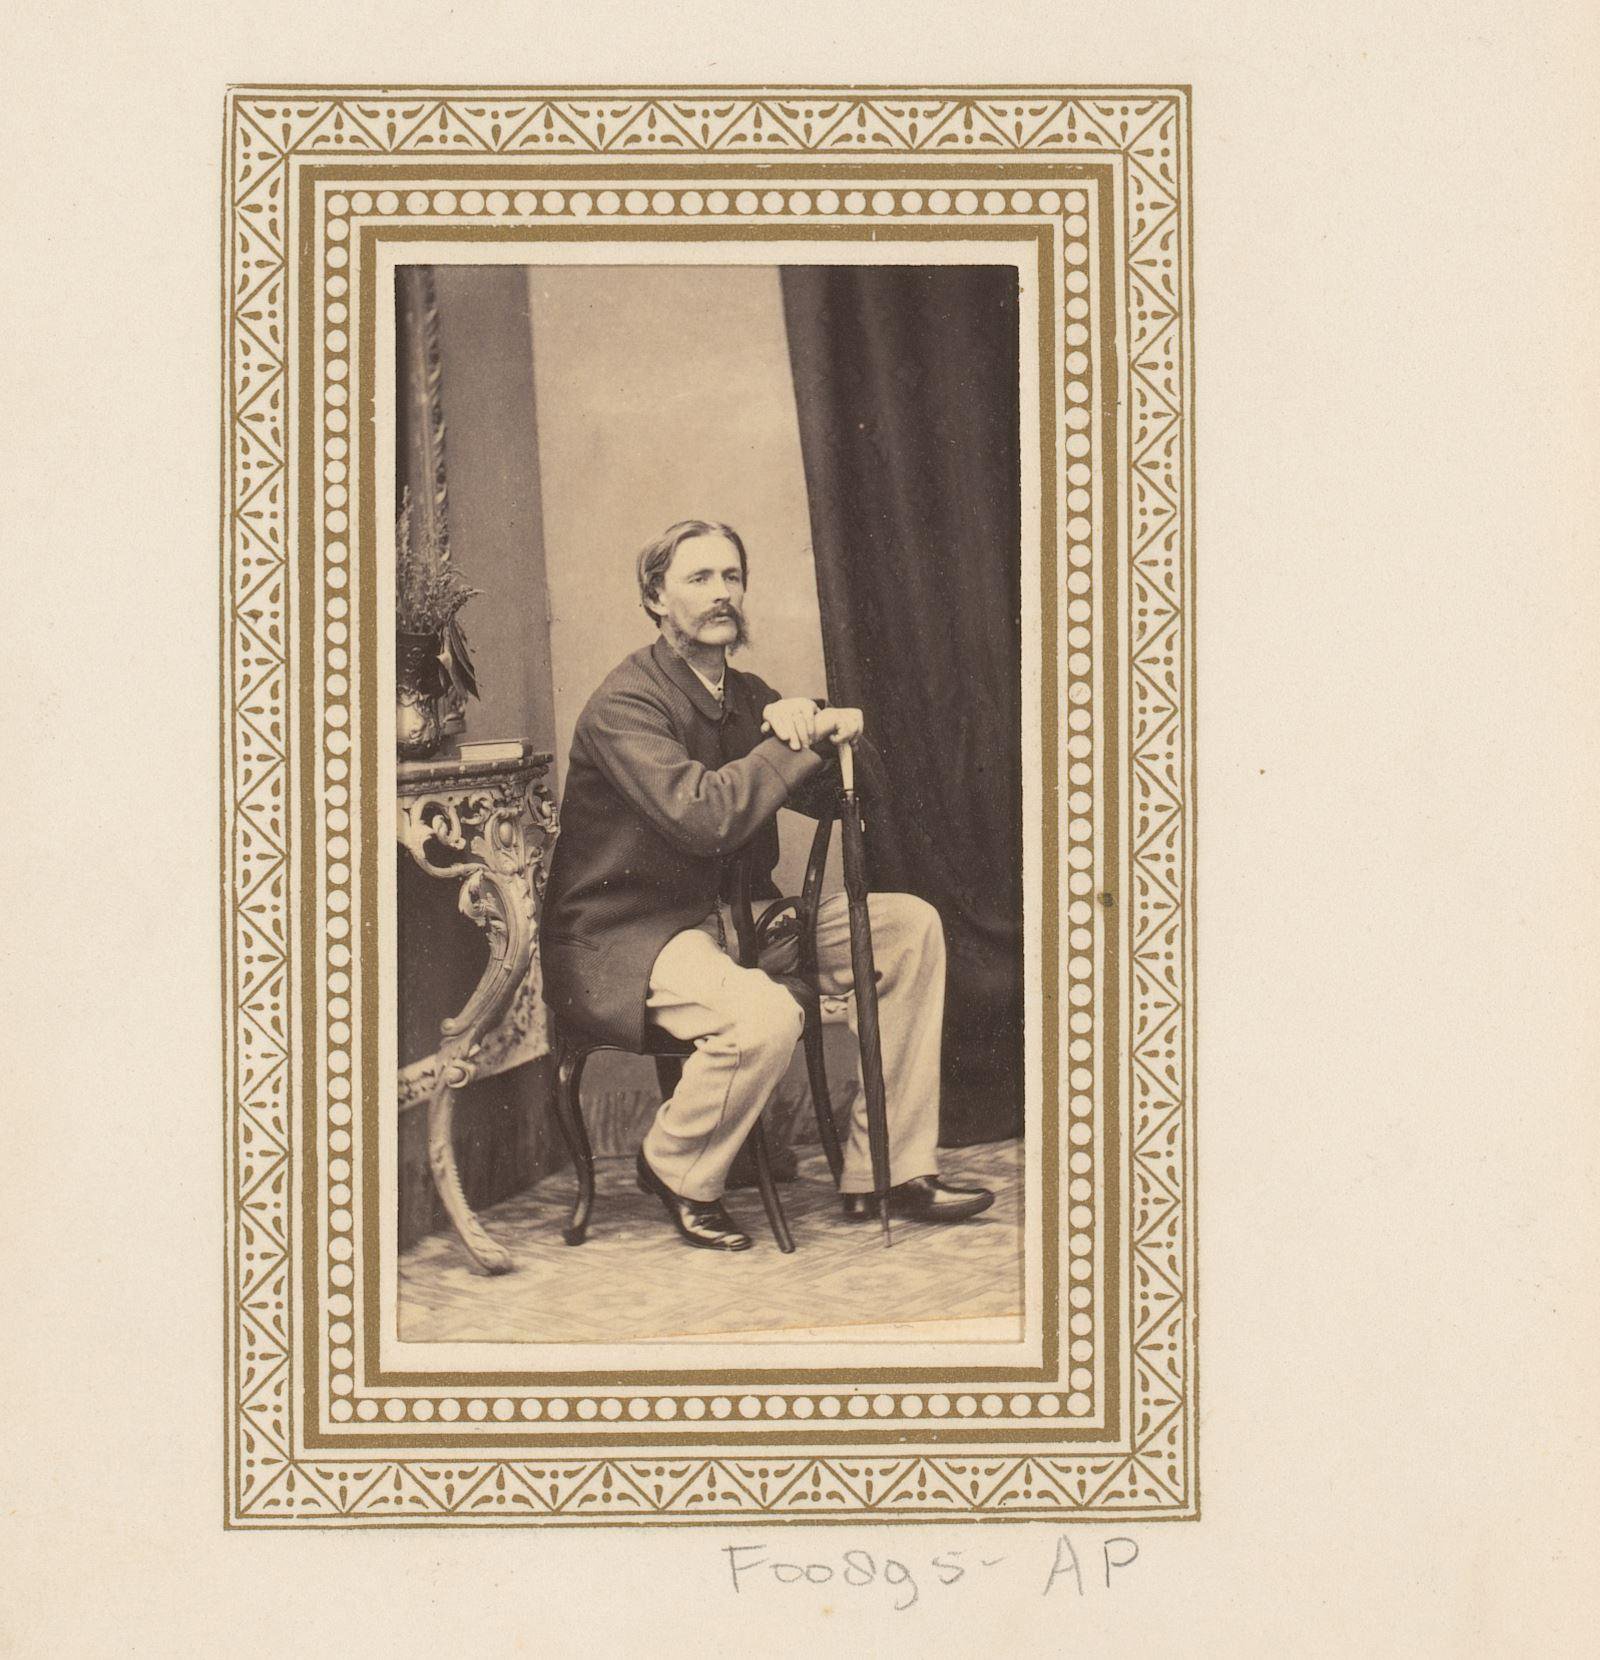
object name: carte de visite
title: Portret van een man met snor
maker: william elliot debenham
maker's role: fotograaf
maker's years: 1839-1924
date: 1861-1865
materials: cardboard, photographic support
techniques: albumen print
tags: sitting figure, moustache, adult man, historical persons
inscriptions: inscription: ‘W. E. Debenham, Photographer/ 158, Regent St./ W.’